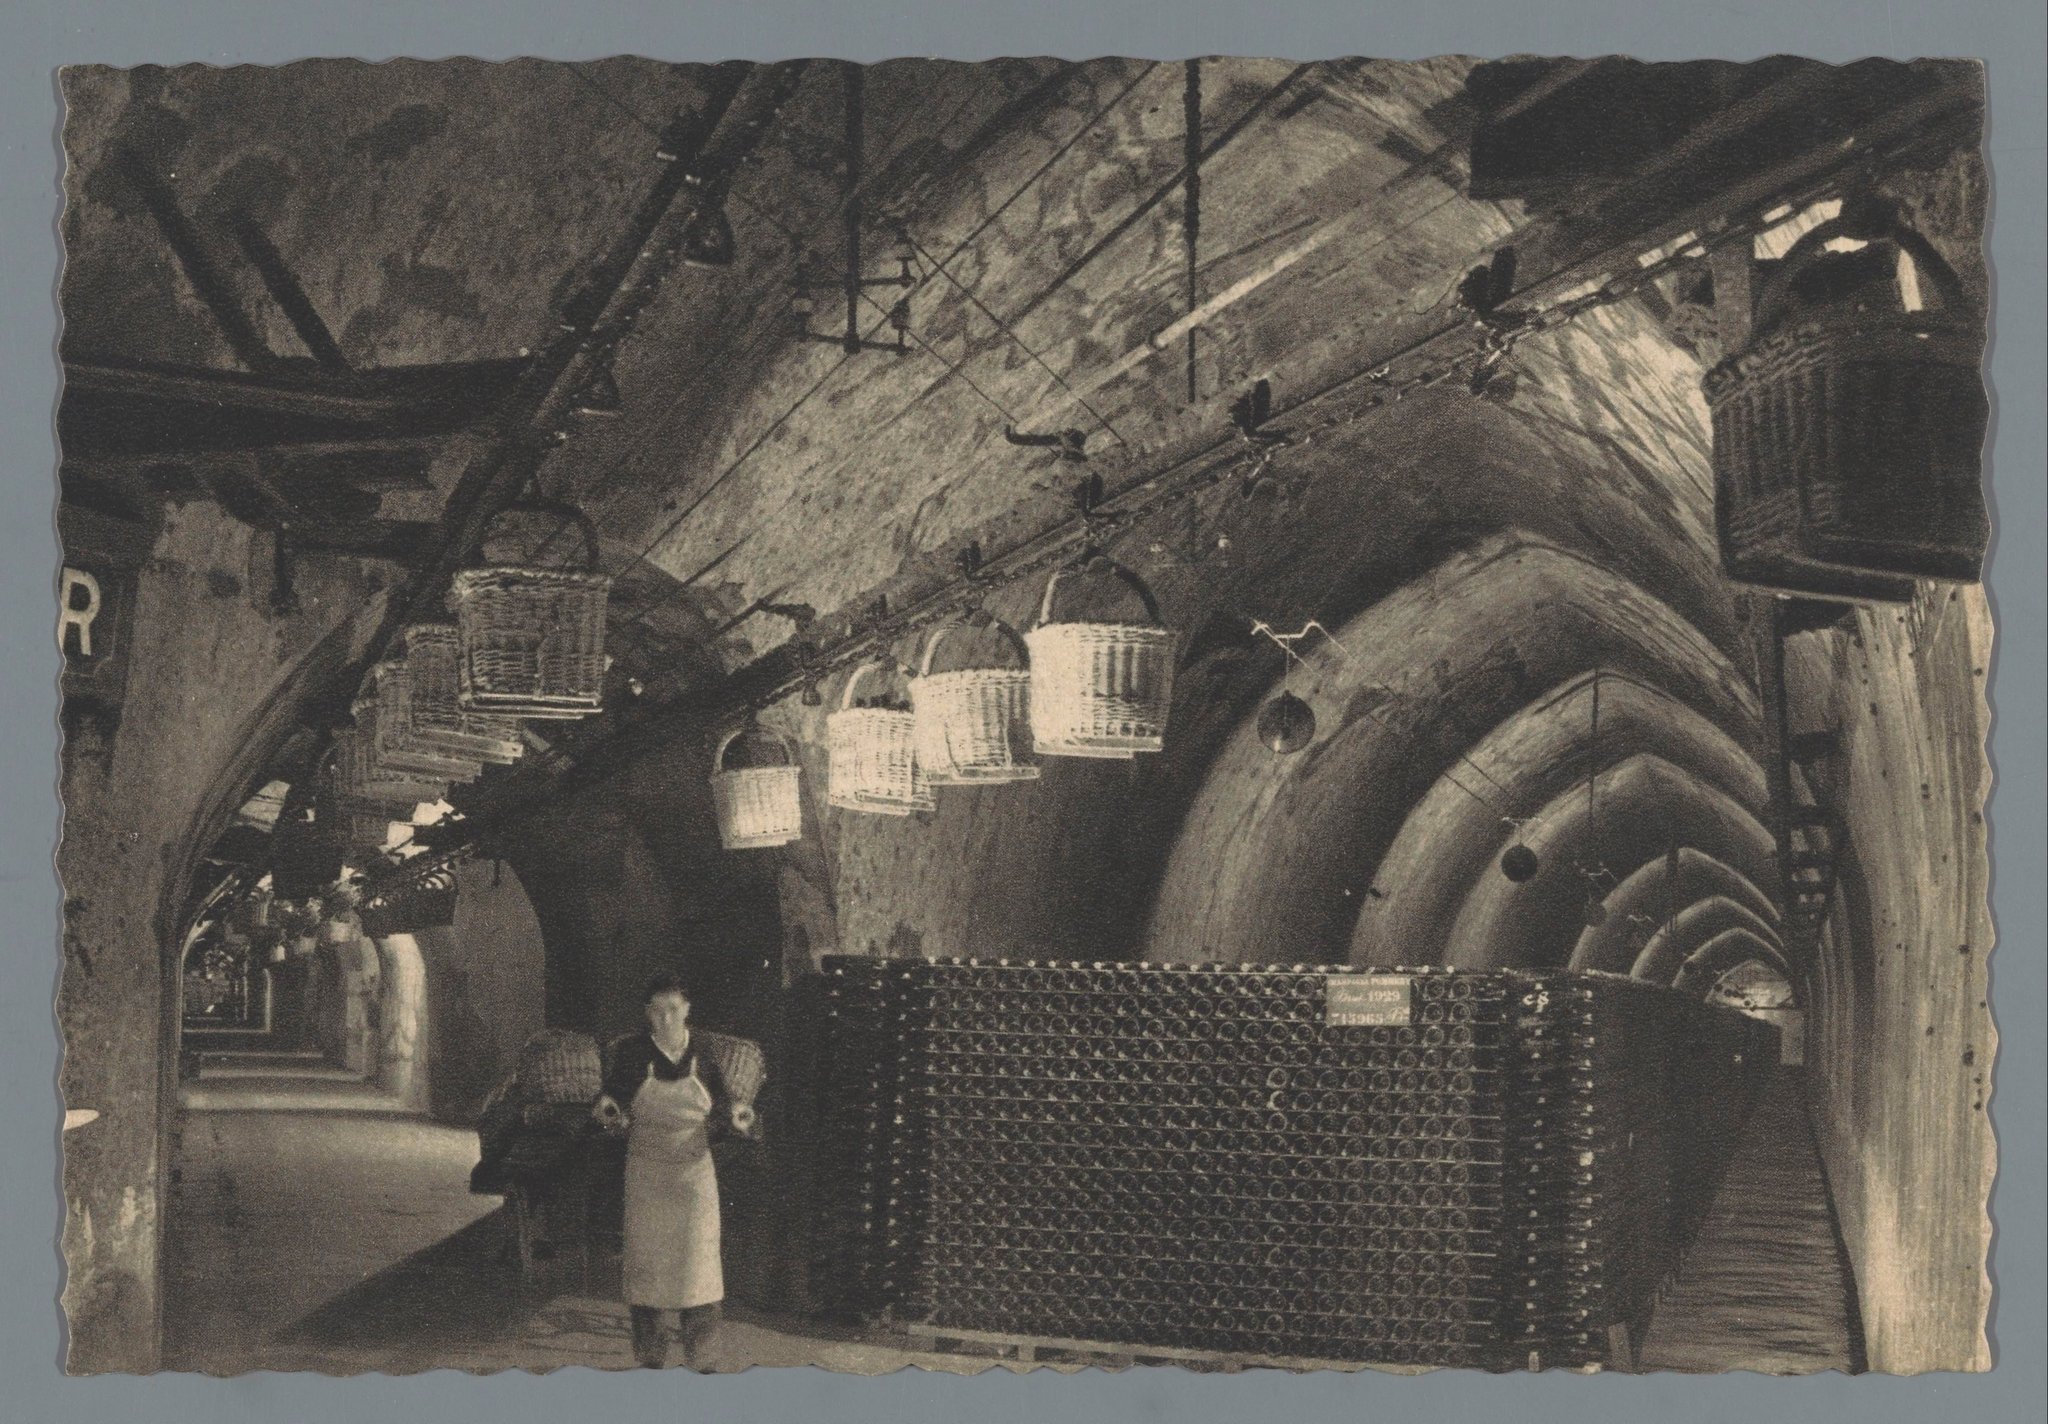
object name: ansichtkaart, prentbriefkaart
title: Jonction de deux galeries et vue du transporteur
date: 1930-1960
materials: paper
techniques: rotogravure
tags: wine-cellar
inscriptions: inscription: ‘Champagne Pommery & Greno - Reims’